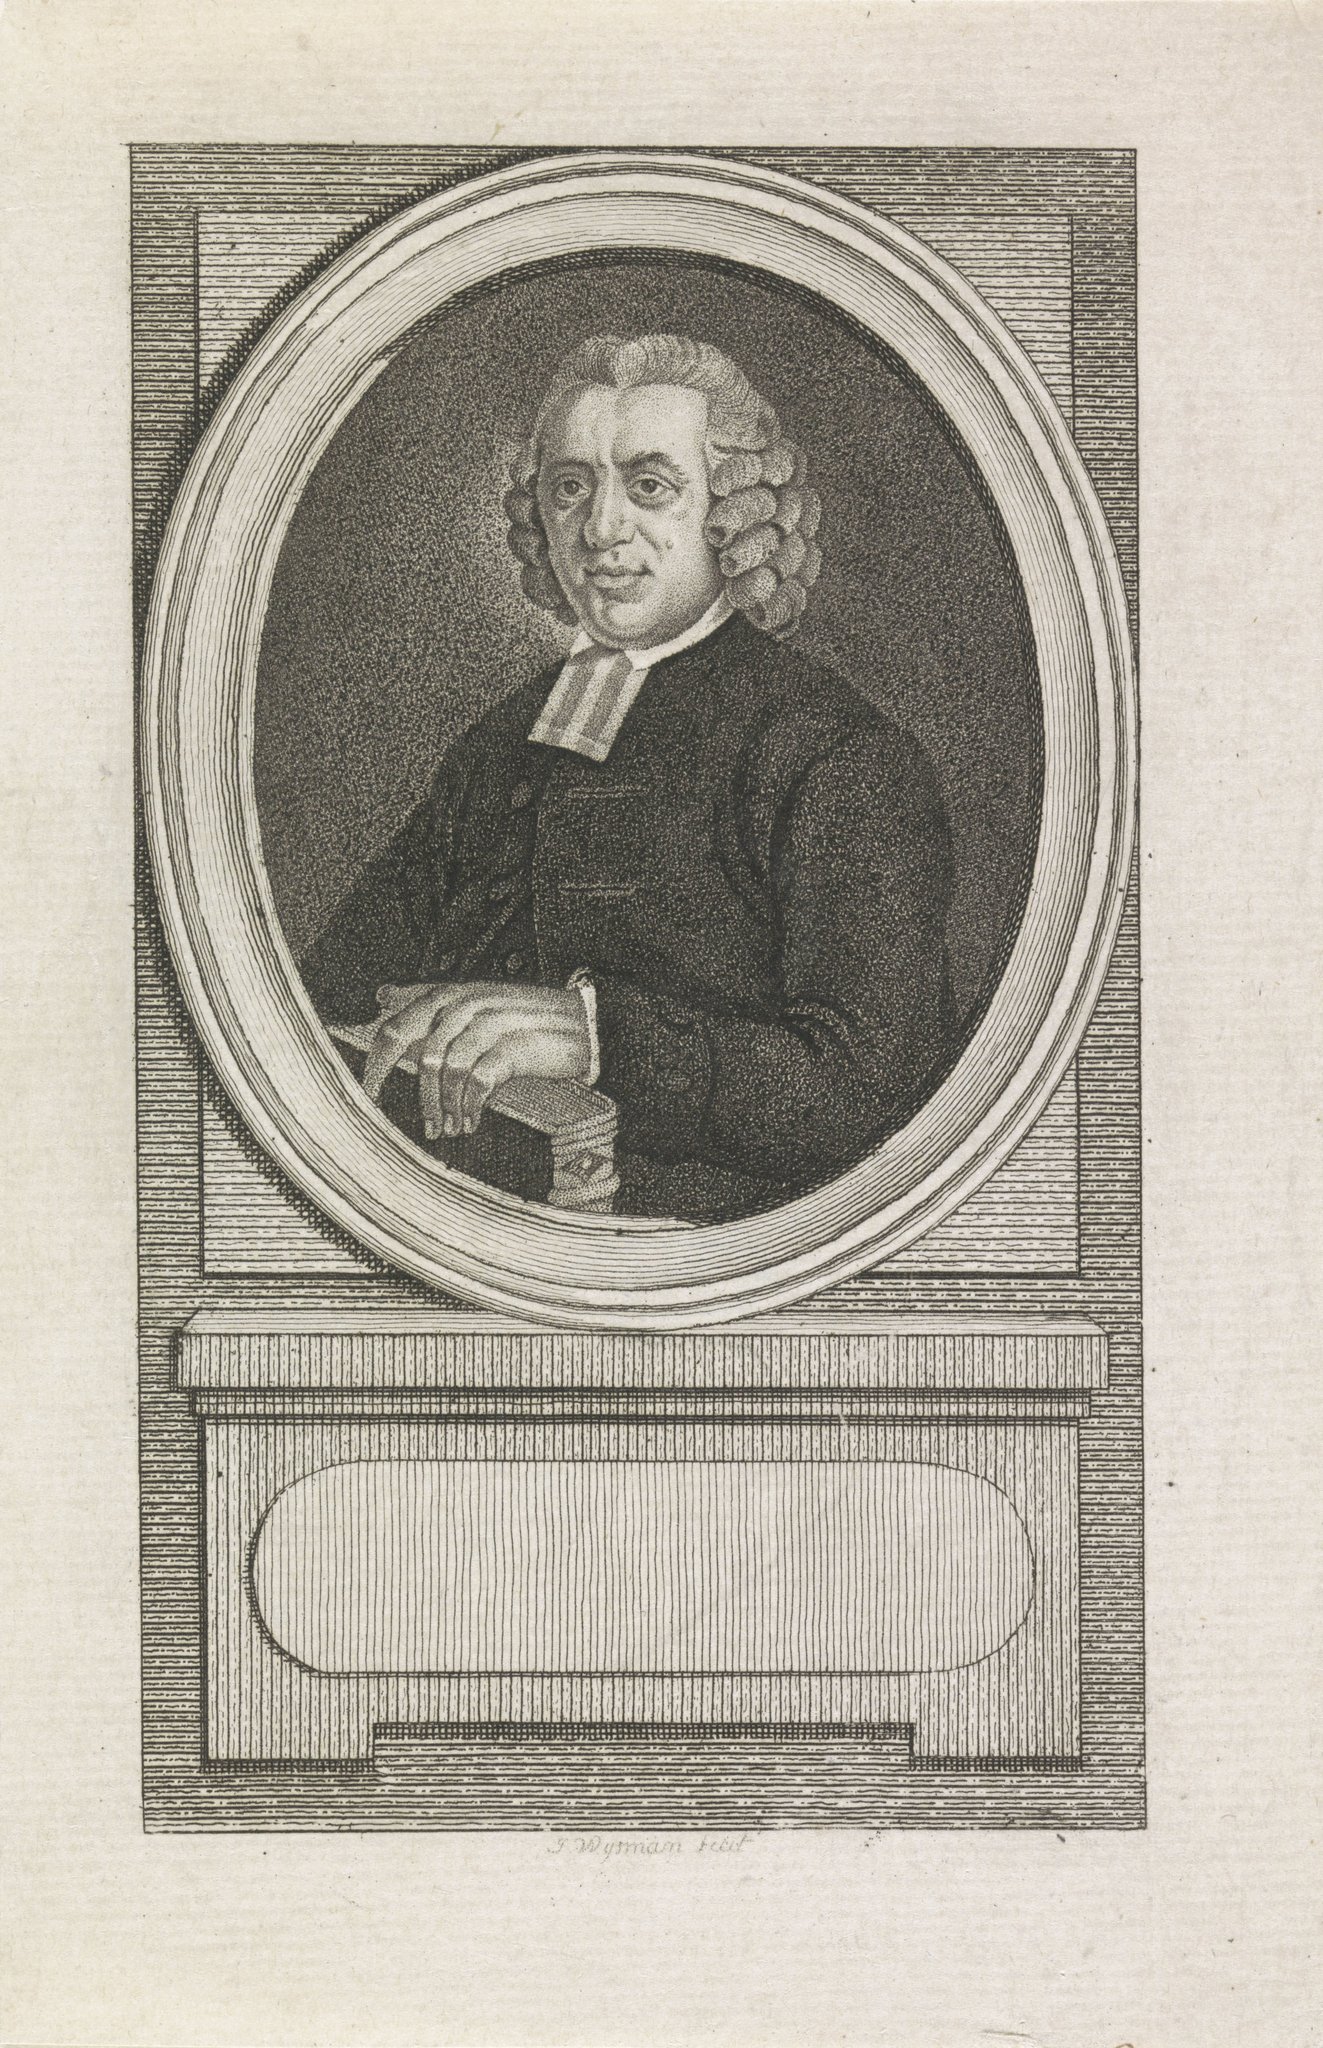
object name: print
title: Portret van ds. Petrus Haack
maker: jacobus wijsman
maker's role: print maker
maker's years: 1768-1827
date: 1789-1824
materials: paper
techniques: engraving, etching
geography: netherlands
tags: the hague, berlin, william i of the netherlands, brielle, amsterdam, petrus haack, ceremonial celebration of installation of a ruler, new ruler taking the oath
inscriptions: collector's mark: Lugt 2228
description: Portret van ds. Petrus Haack, de predikant die de ceremonie leidde bij de inhuldiging van Willem Frederik, prins van Oranje als souverein vorst in de Nieuwe Kerk te Amsterdam op 30 maart 1814, waar de vorst de eed aflegde op de grondwet.